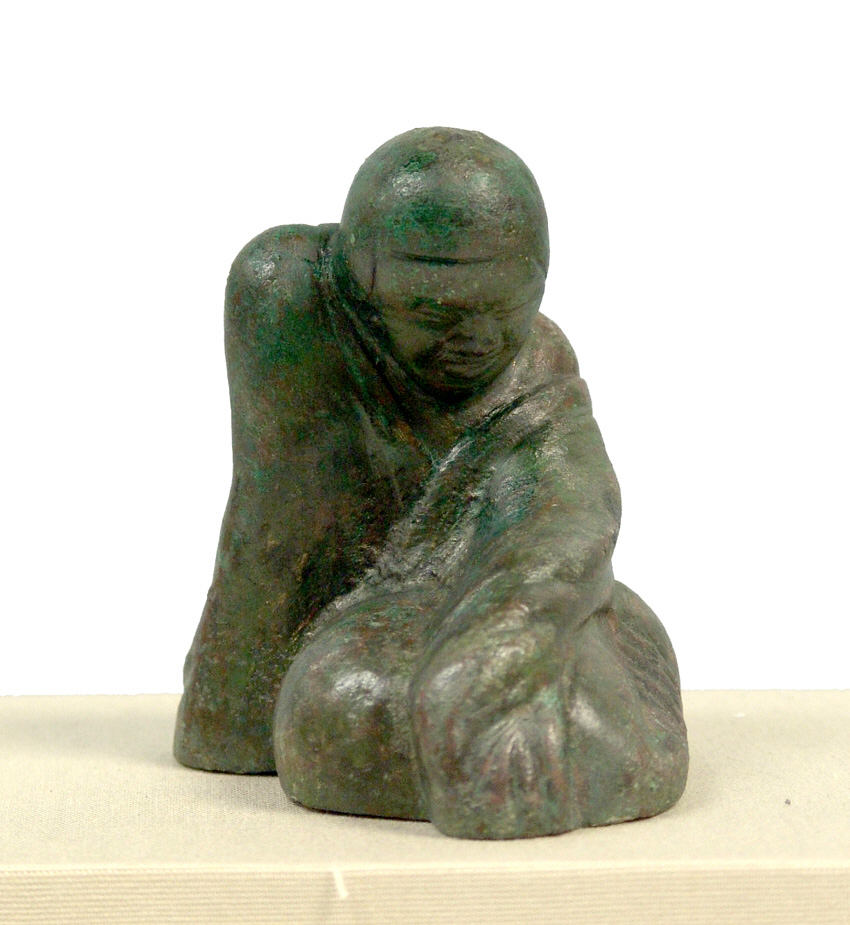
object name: weight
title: Weight in the Shape of Liubo Game Player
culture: chinese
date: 206 BCE-220 CE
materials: bronze, lead